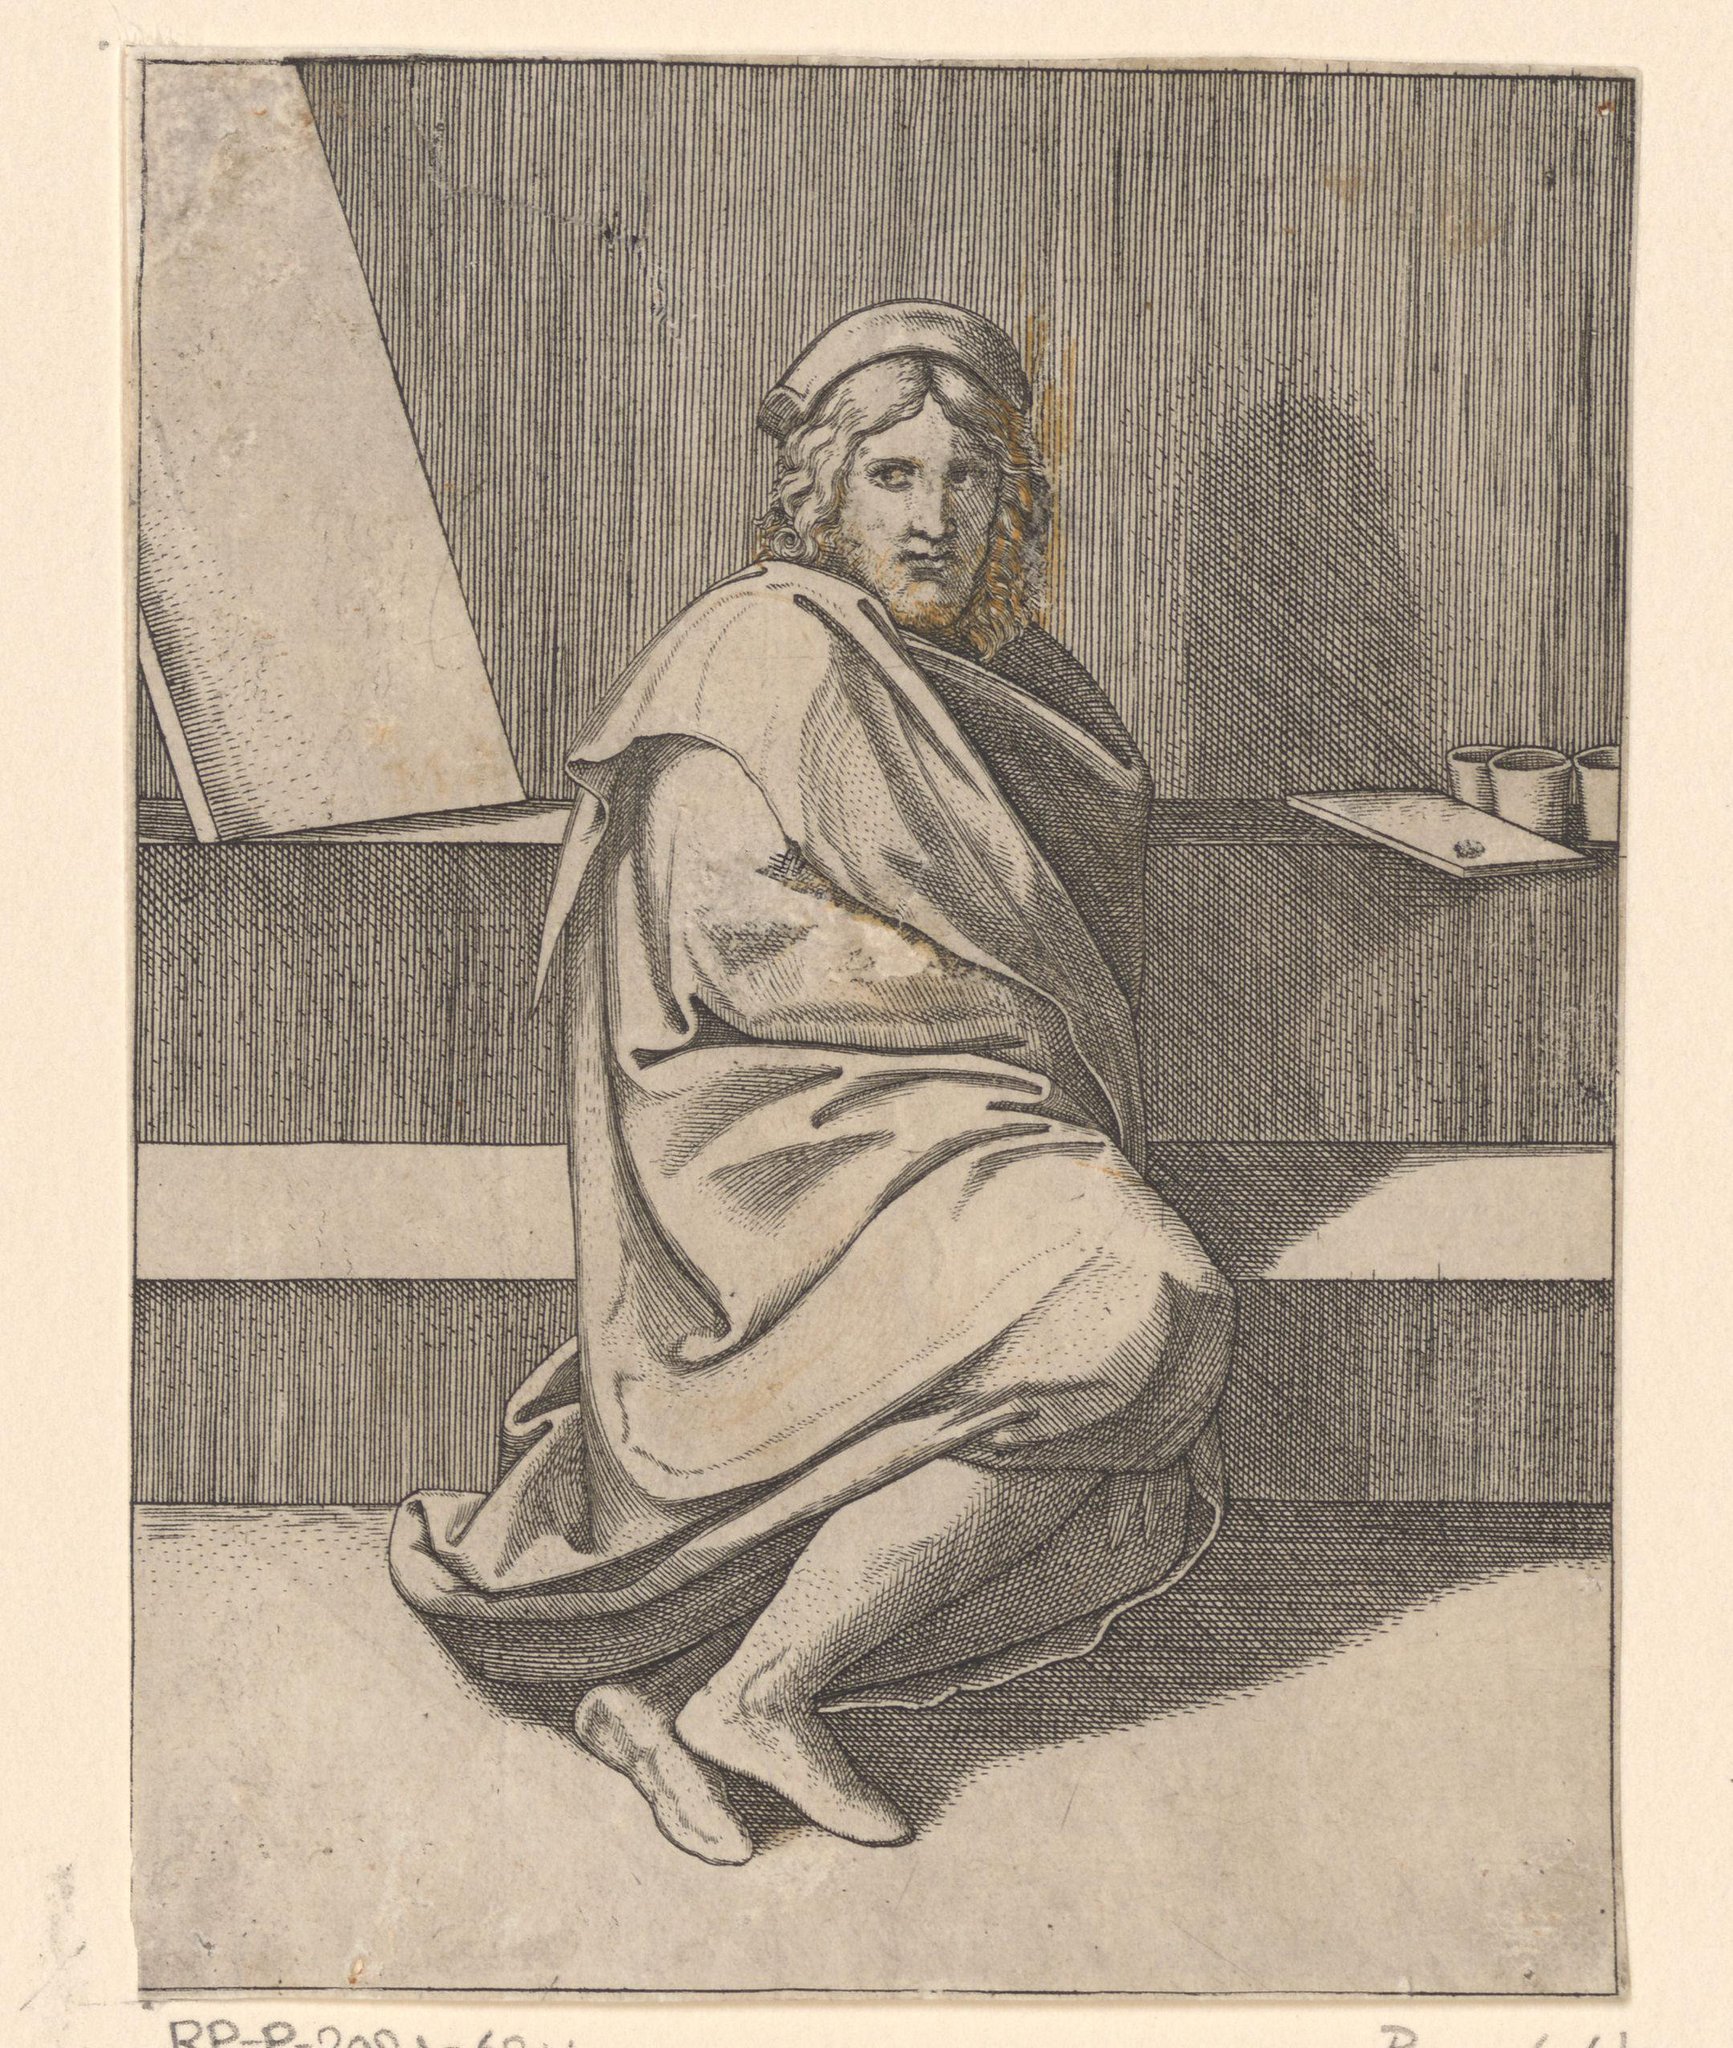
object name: print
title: Portret van Rafaël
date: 1510-1699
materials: paper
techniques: engraving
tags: rome, painter, rafaël, historical persons, portrait, self-portrait of painter